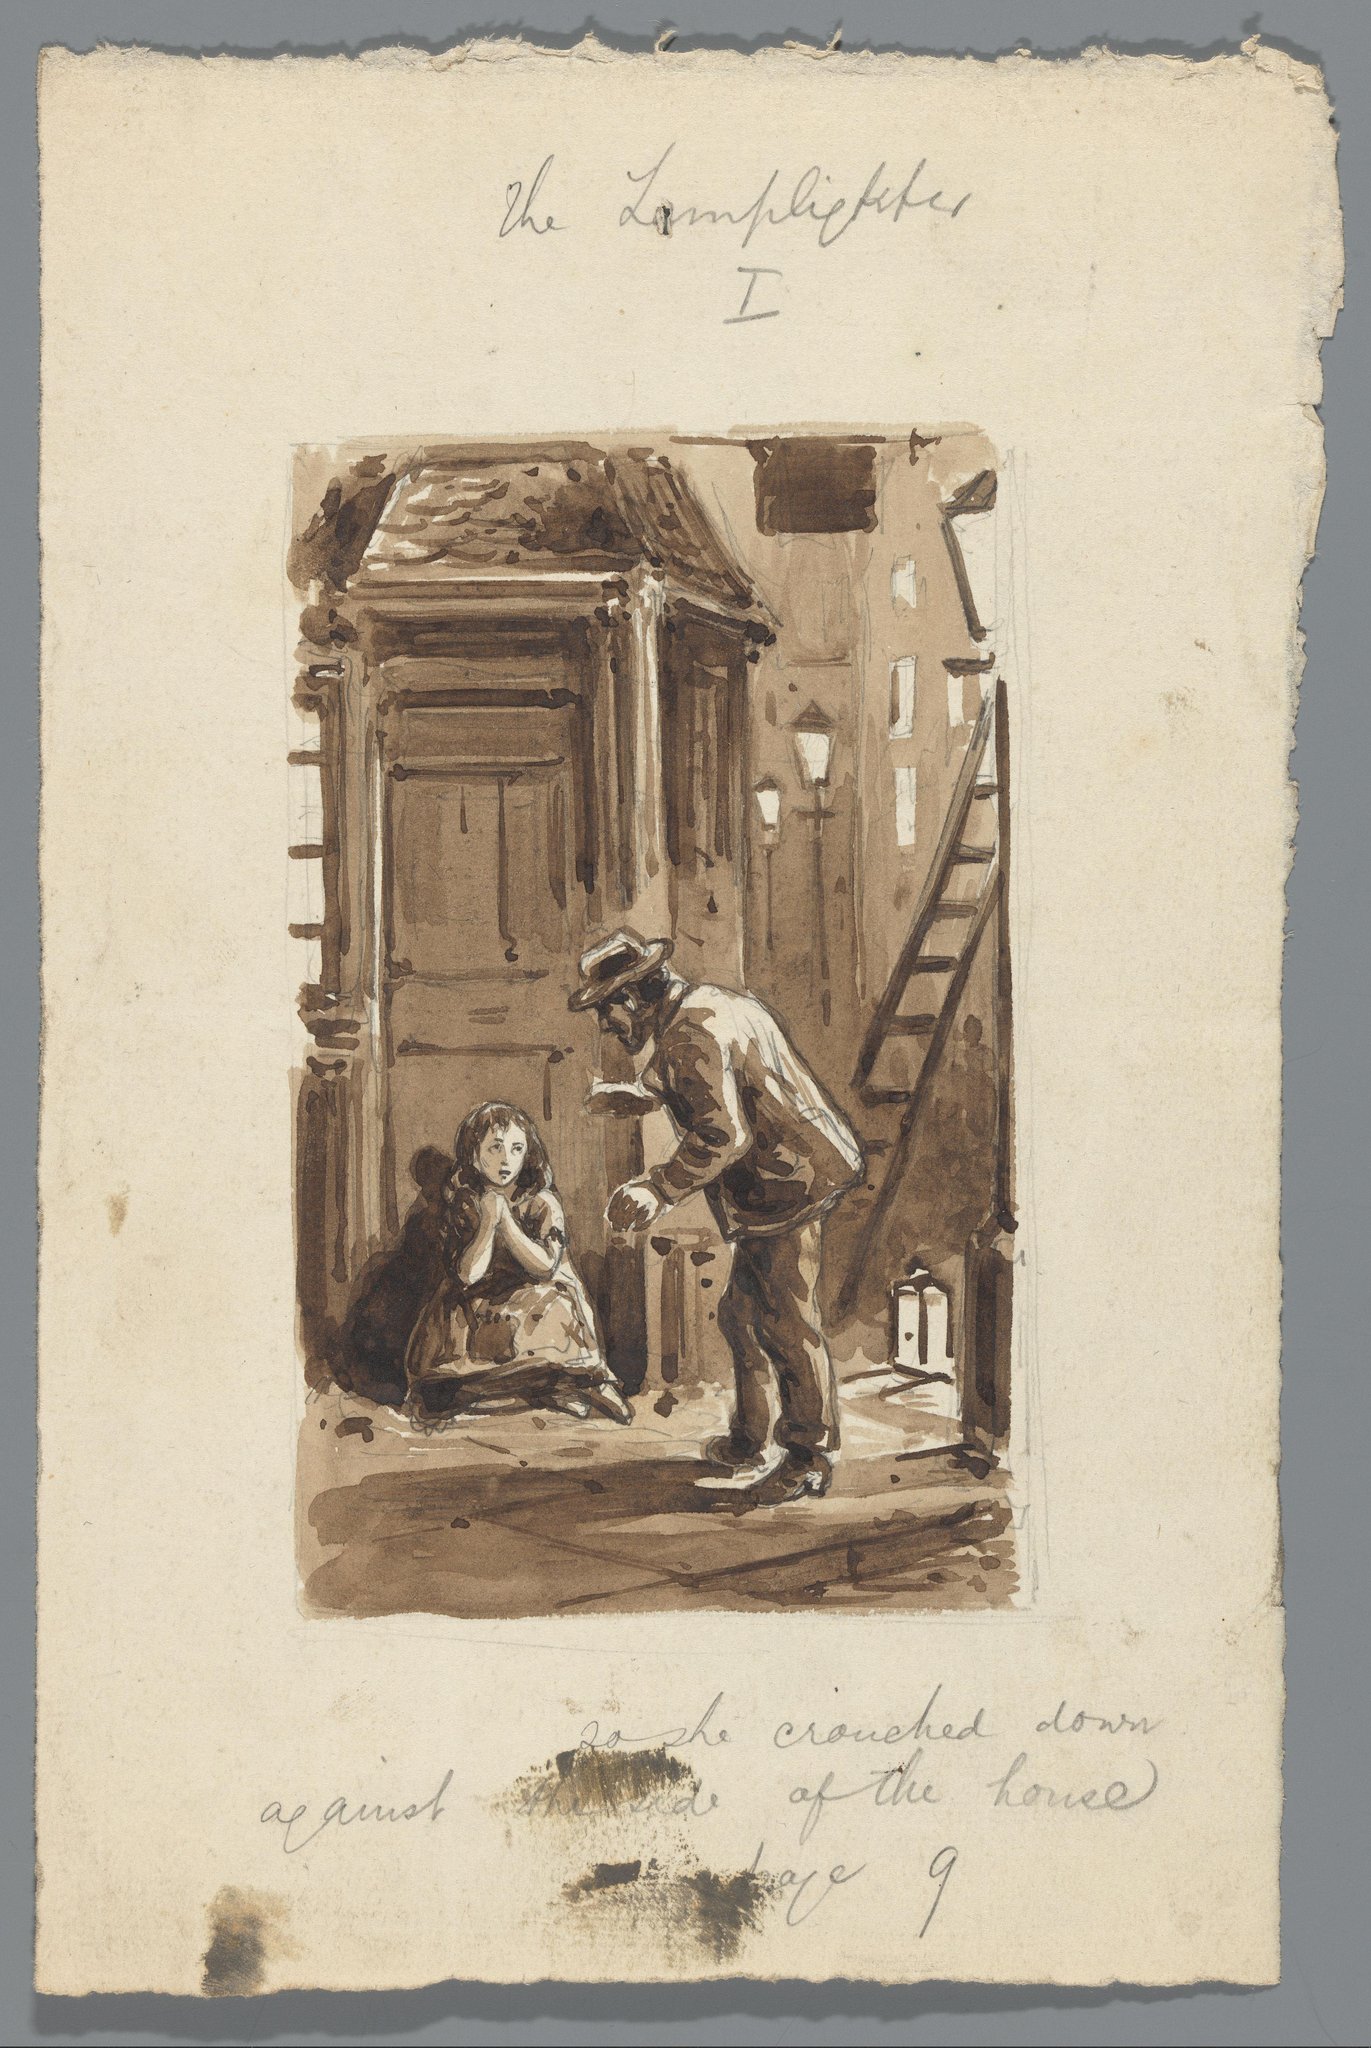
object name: design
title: Trueman Flint stuit op de huilende Gerty, rouwend om haar kitten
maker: joseph ludovic scheidel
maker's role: draughtsman, painter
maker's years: 1848-1895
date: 1854-1895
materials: paper, pencil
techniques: brush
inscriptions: annotation: ‘Engels citaat verwijzend naar de geïllustreerde passage’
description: Ontwerp voor een boekillustratie in Maria Susanna Cummins, "The Lamplighter".